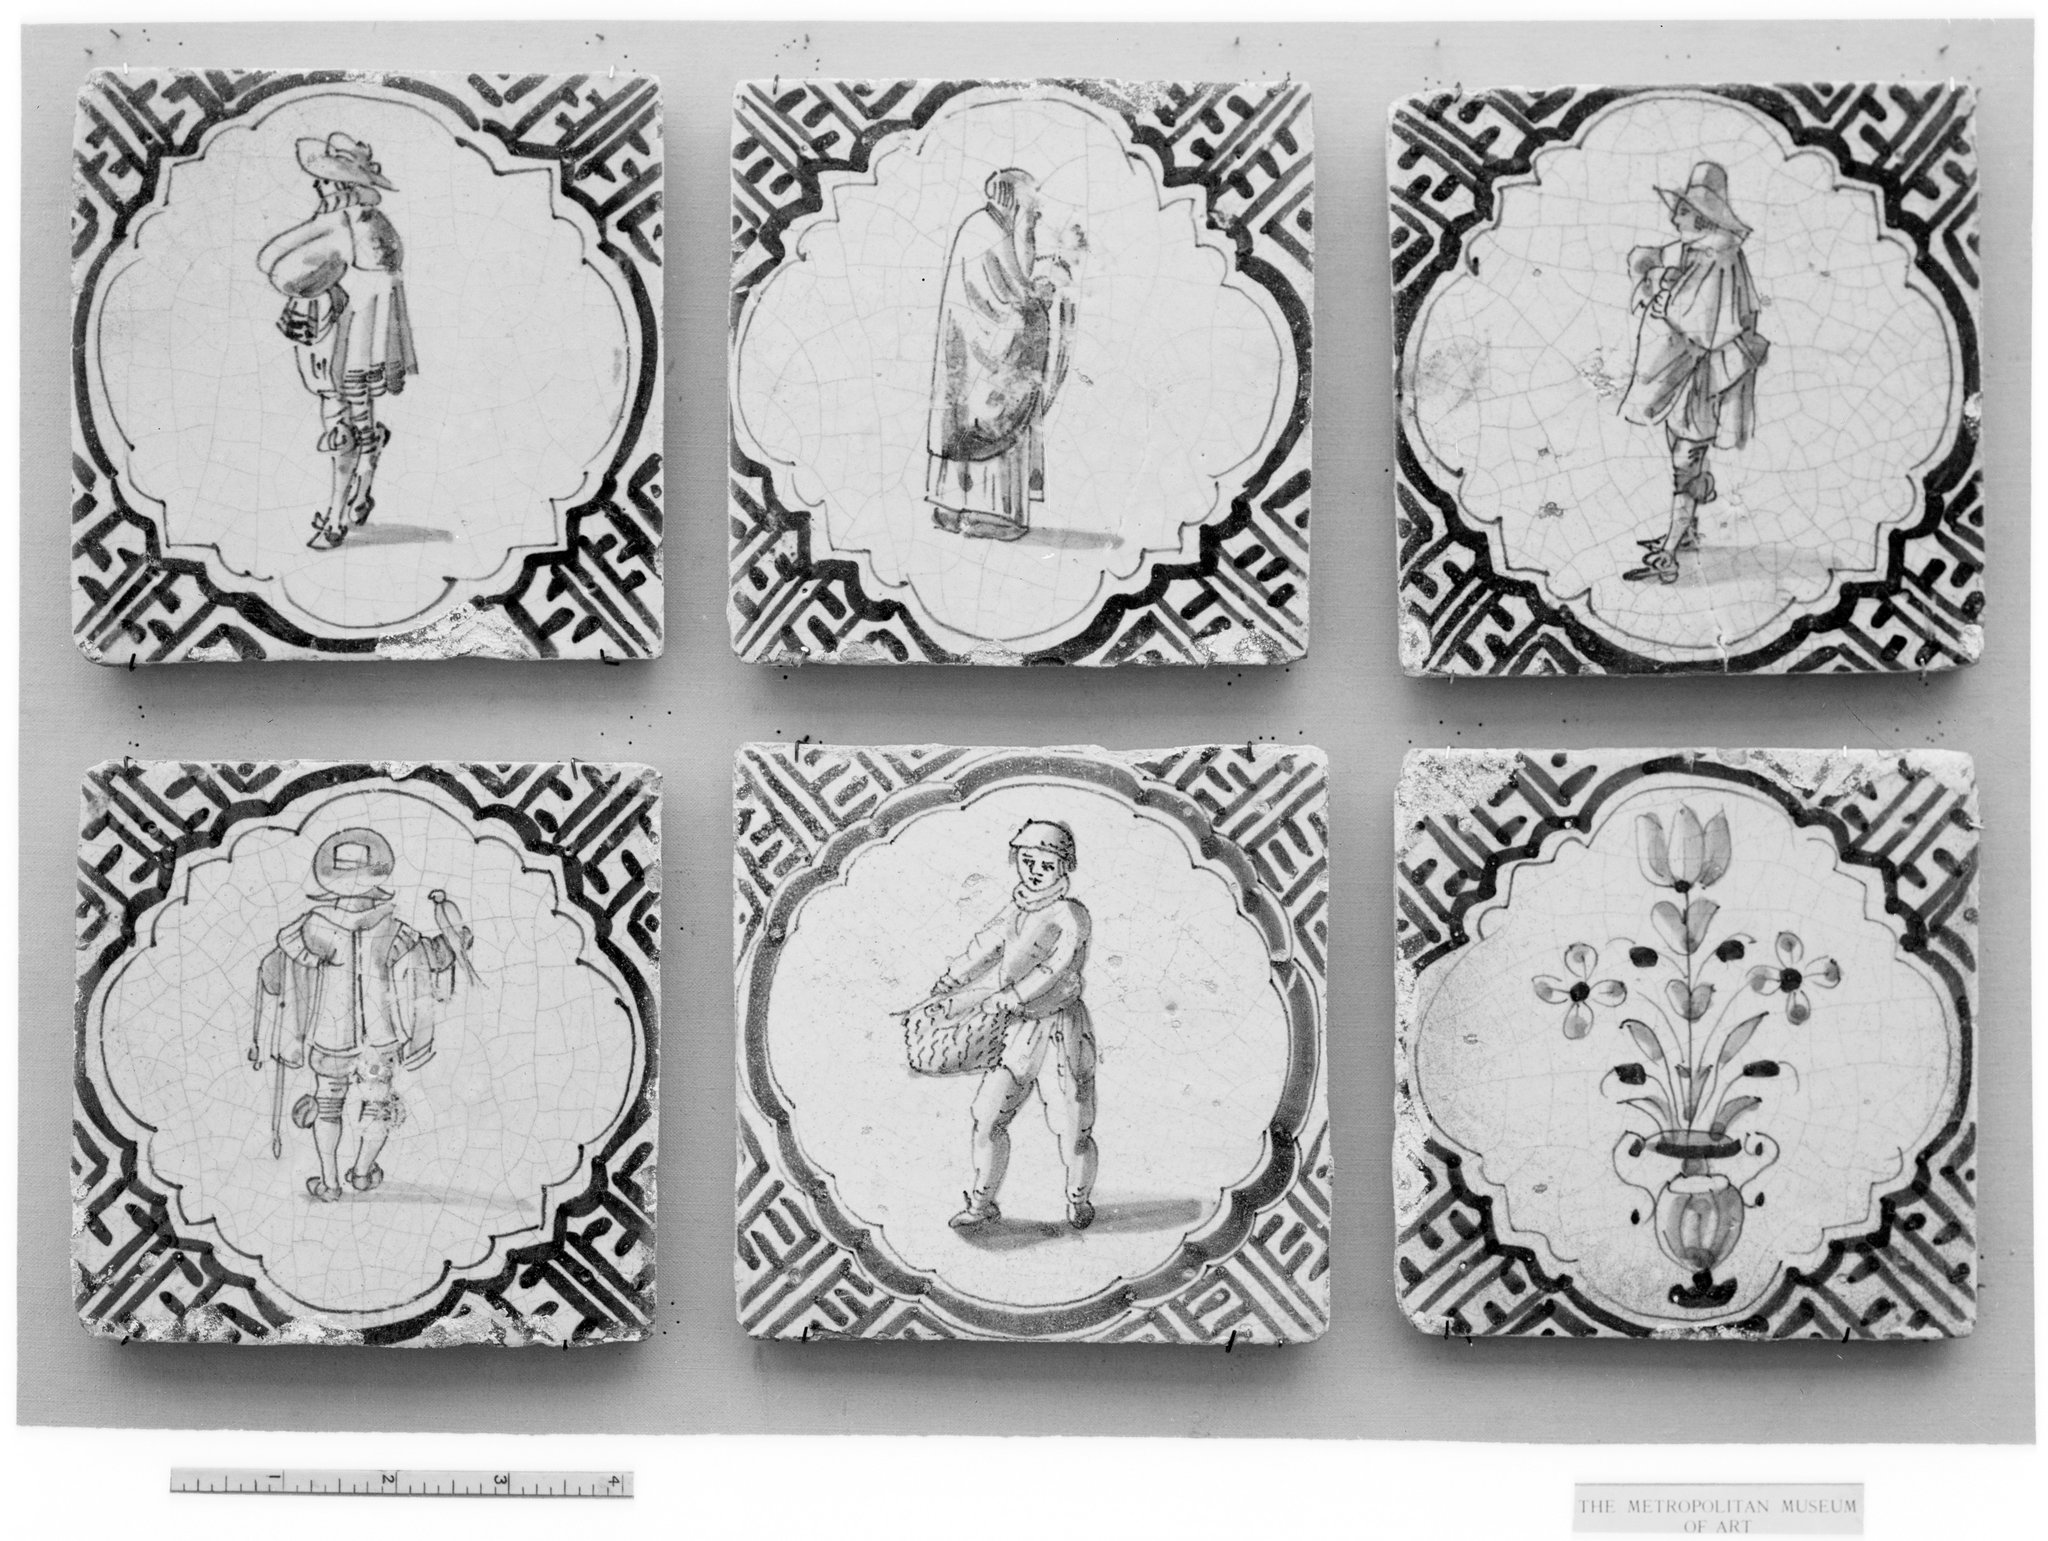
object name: tile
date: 1620-1640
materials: earthenware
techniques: glazing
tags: men,flowers